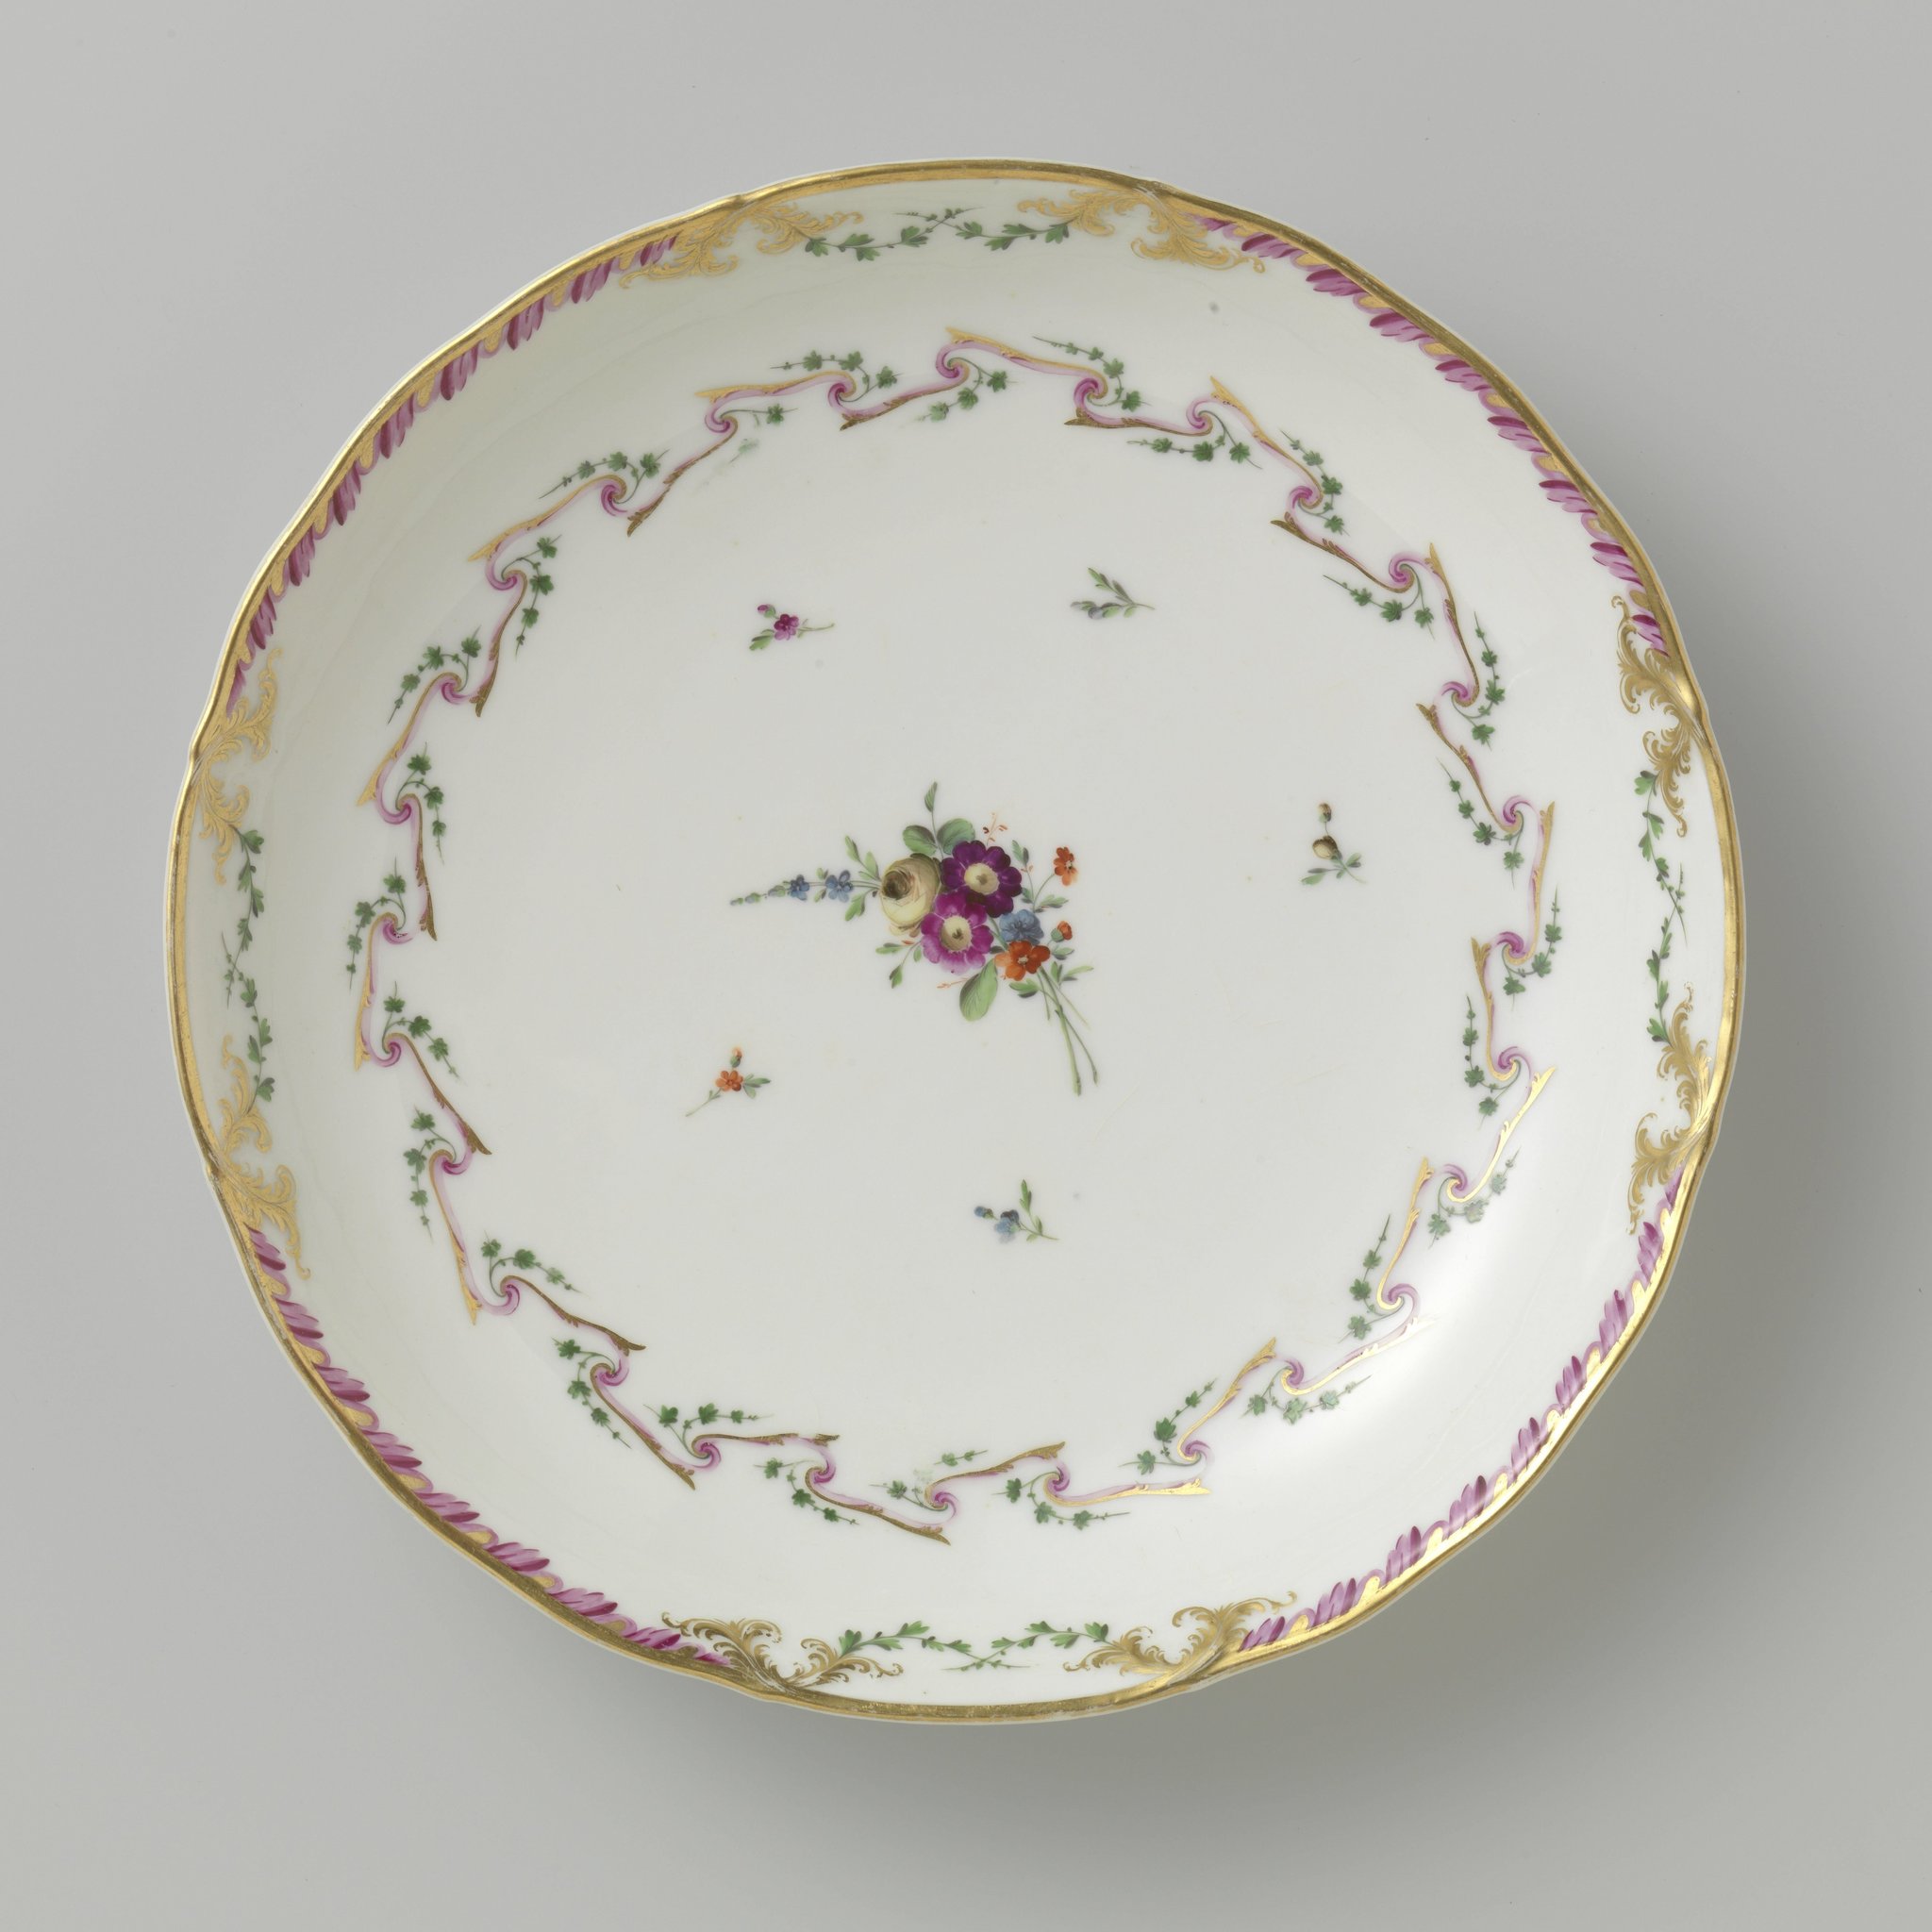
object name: dish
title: Schaal, rond en diep, behorend bij een servies versierd met geslingerd lintmotief met bladertakken, bloemboeketten en gestrooide bloemtakken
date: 1780-1820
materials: porcelain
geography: loosdrecht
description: Schaal, rond en diep , behorend bij een servies van porselein versierd met een geslingerd lintmotief in paars en goud met groene bladertakken, bloemboeketten en gestrooide bloemtakken. Randen licht gegolfd, met decoratie in goud met paars bladmotief waartussen groen gekruist bladmotief. Gemerkt: M.O.L. en Amstel.